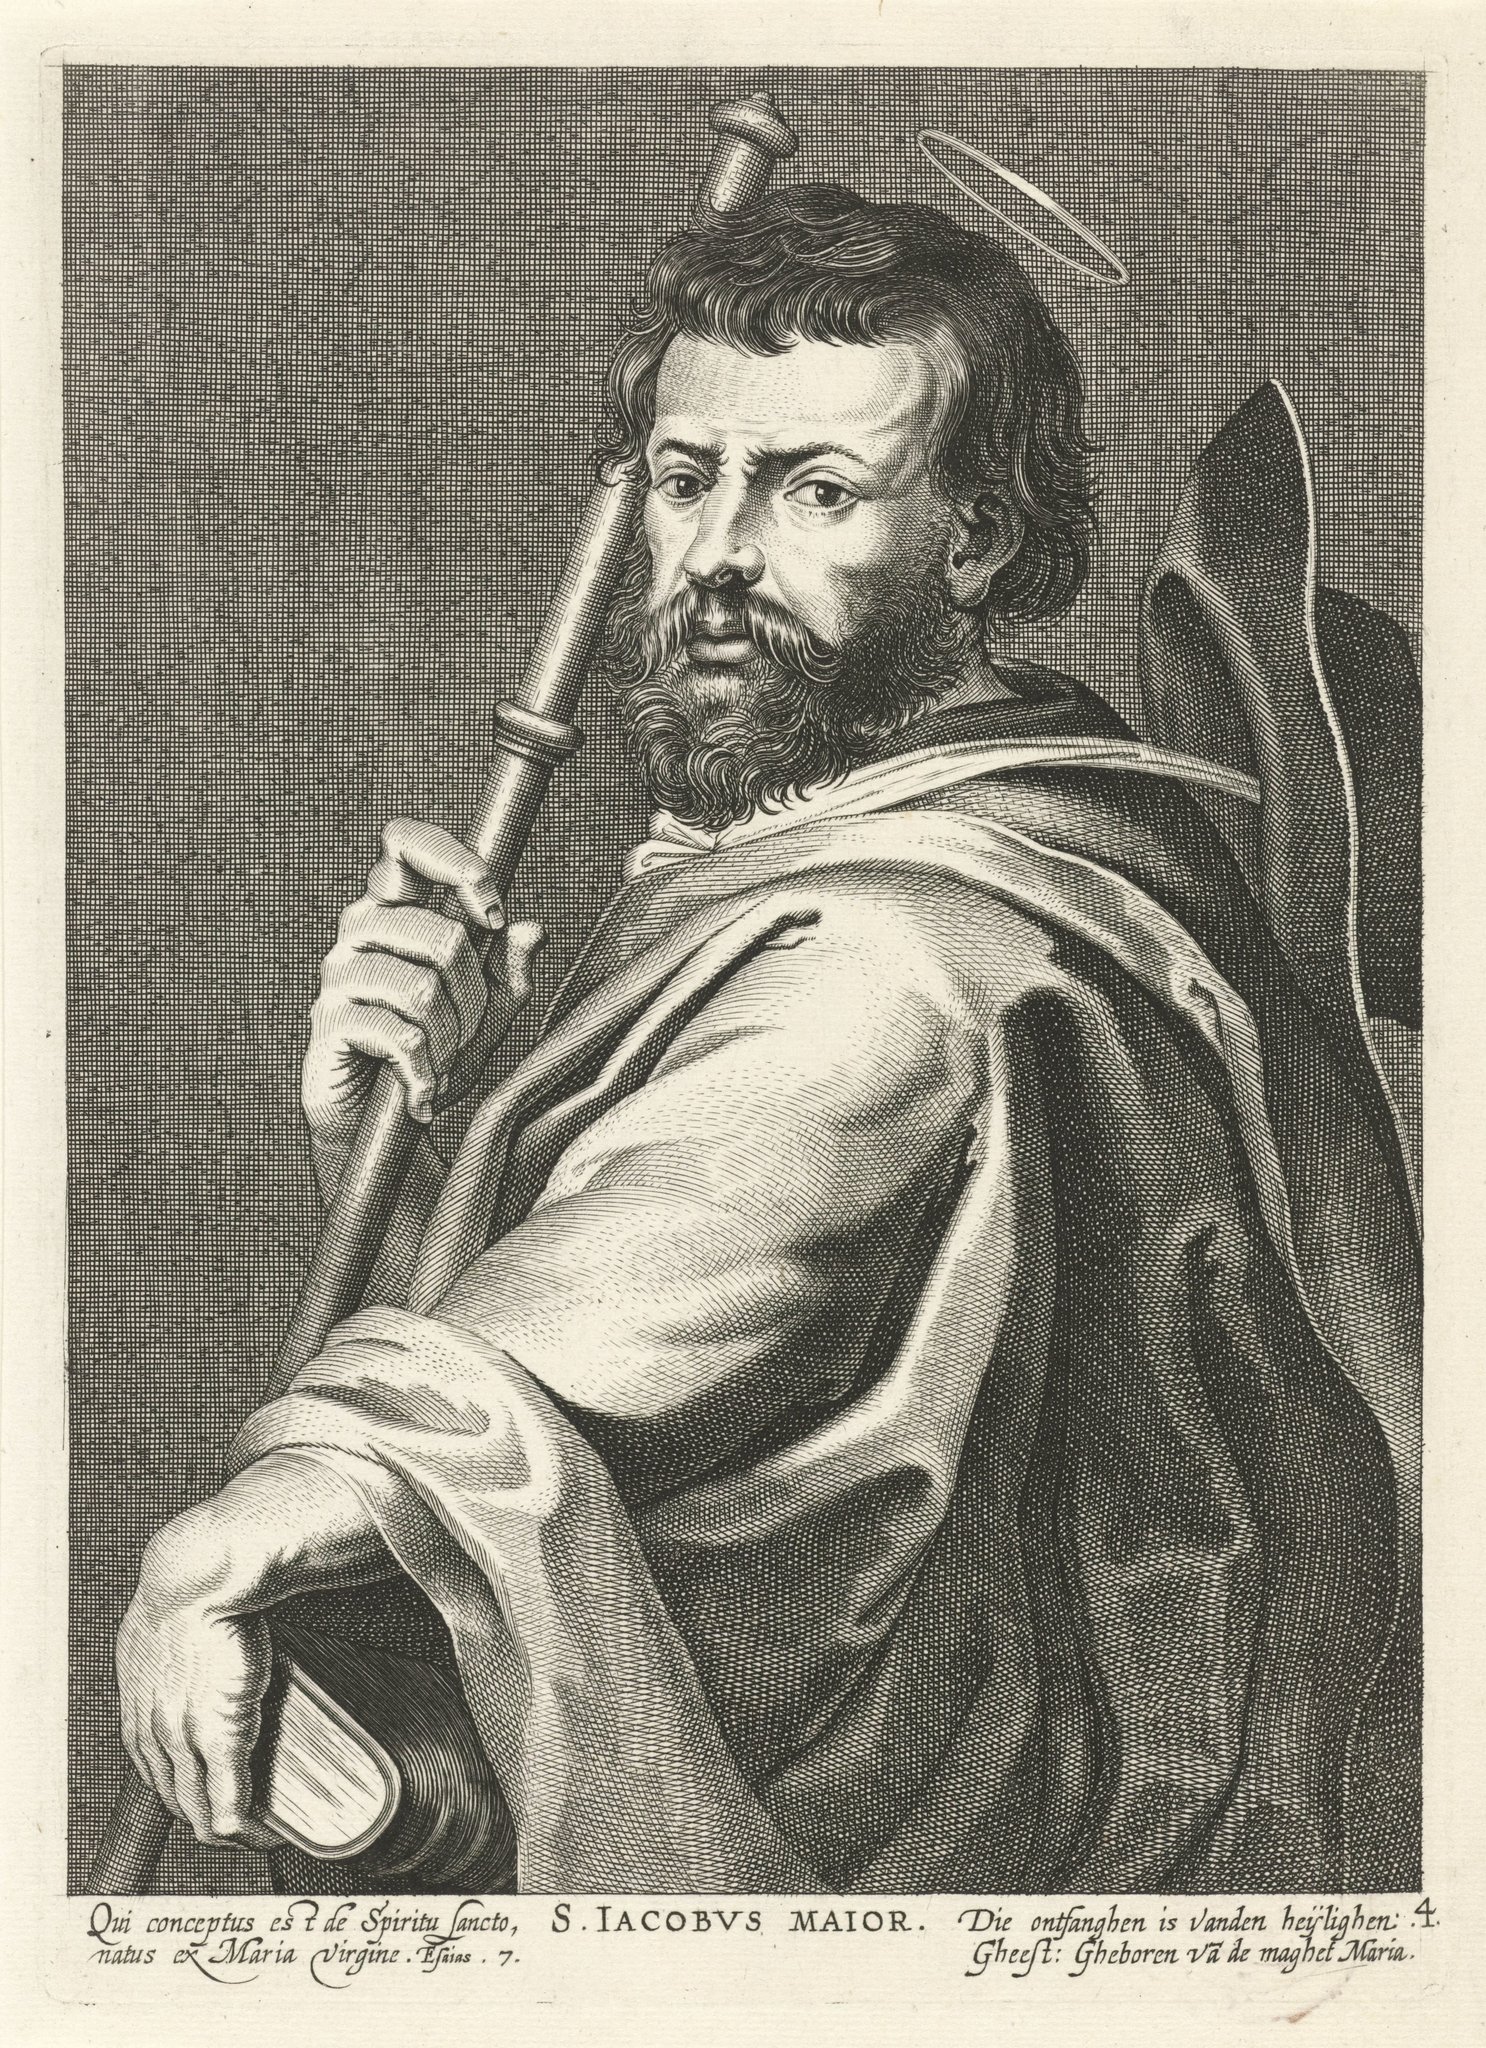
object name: print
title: Christus en dertien apostelen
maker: nicolaes ryckmans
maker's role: print maker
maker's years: 1595-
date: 1616-1636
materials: paper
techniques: engraving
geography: southern netherlands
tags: the apostle james the great; possible attributes: book, pilgrim's cloak, hat, shell, staff, and wallet, scroll, sword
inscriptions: collector's mark: Lugt 240